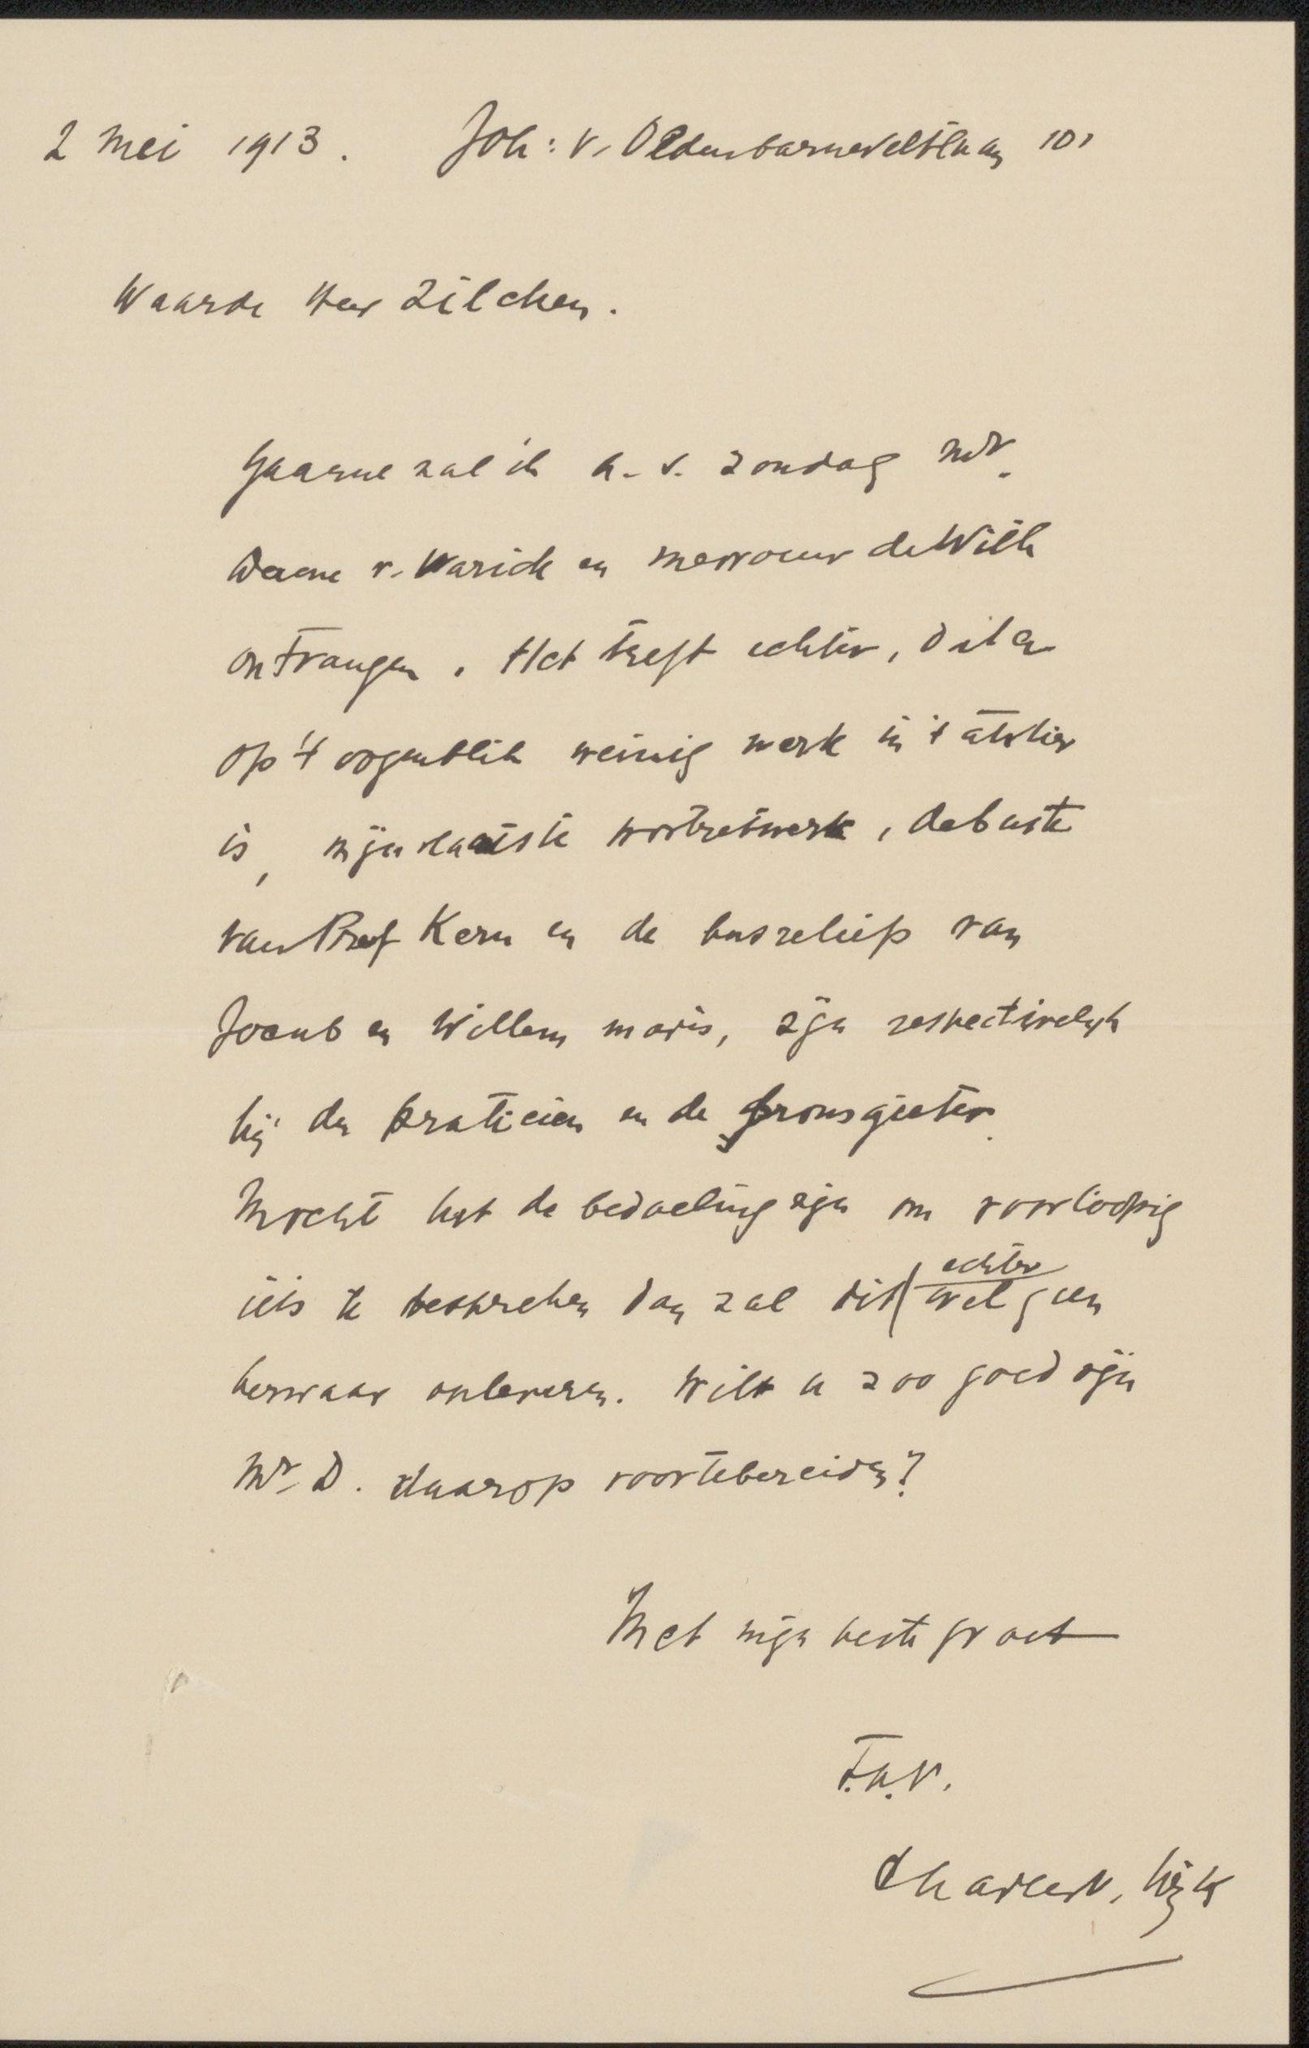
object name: letter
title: Brief aan Philip Zilcken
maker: charles van wijk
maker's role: sculptor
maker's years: 1875-1917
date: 1913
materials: ink, paper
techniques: pen, writing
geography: the hague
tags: the hague, painter, draughtsman, willem maris, print maker, jacob maris, utrecht, philip zilcken, sculpture, workshop, studio of the artist (in general), historical persons (portraits and scenes from the life)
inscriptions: collector's mark: ‘RPK’